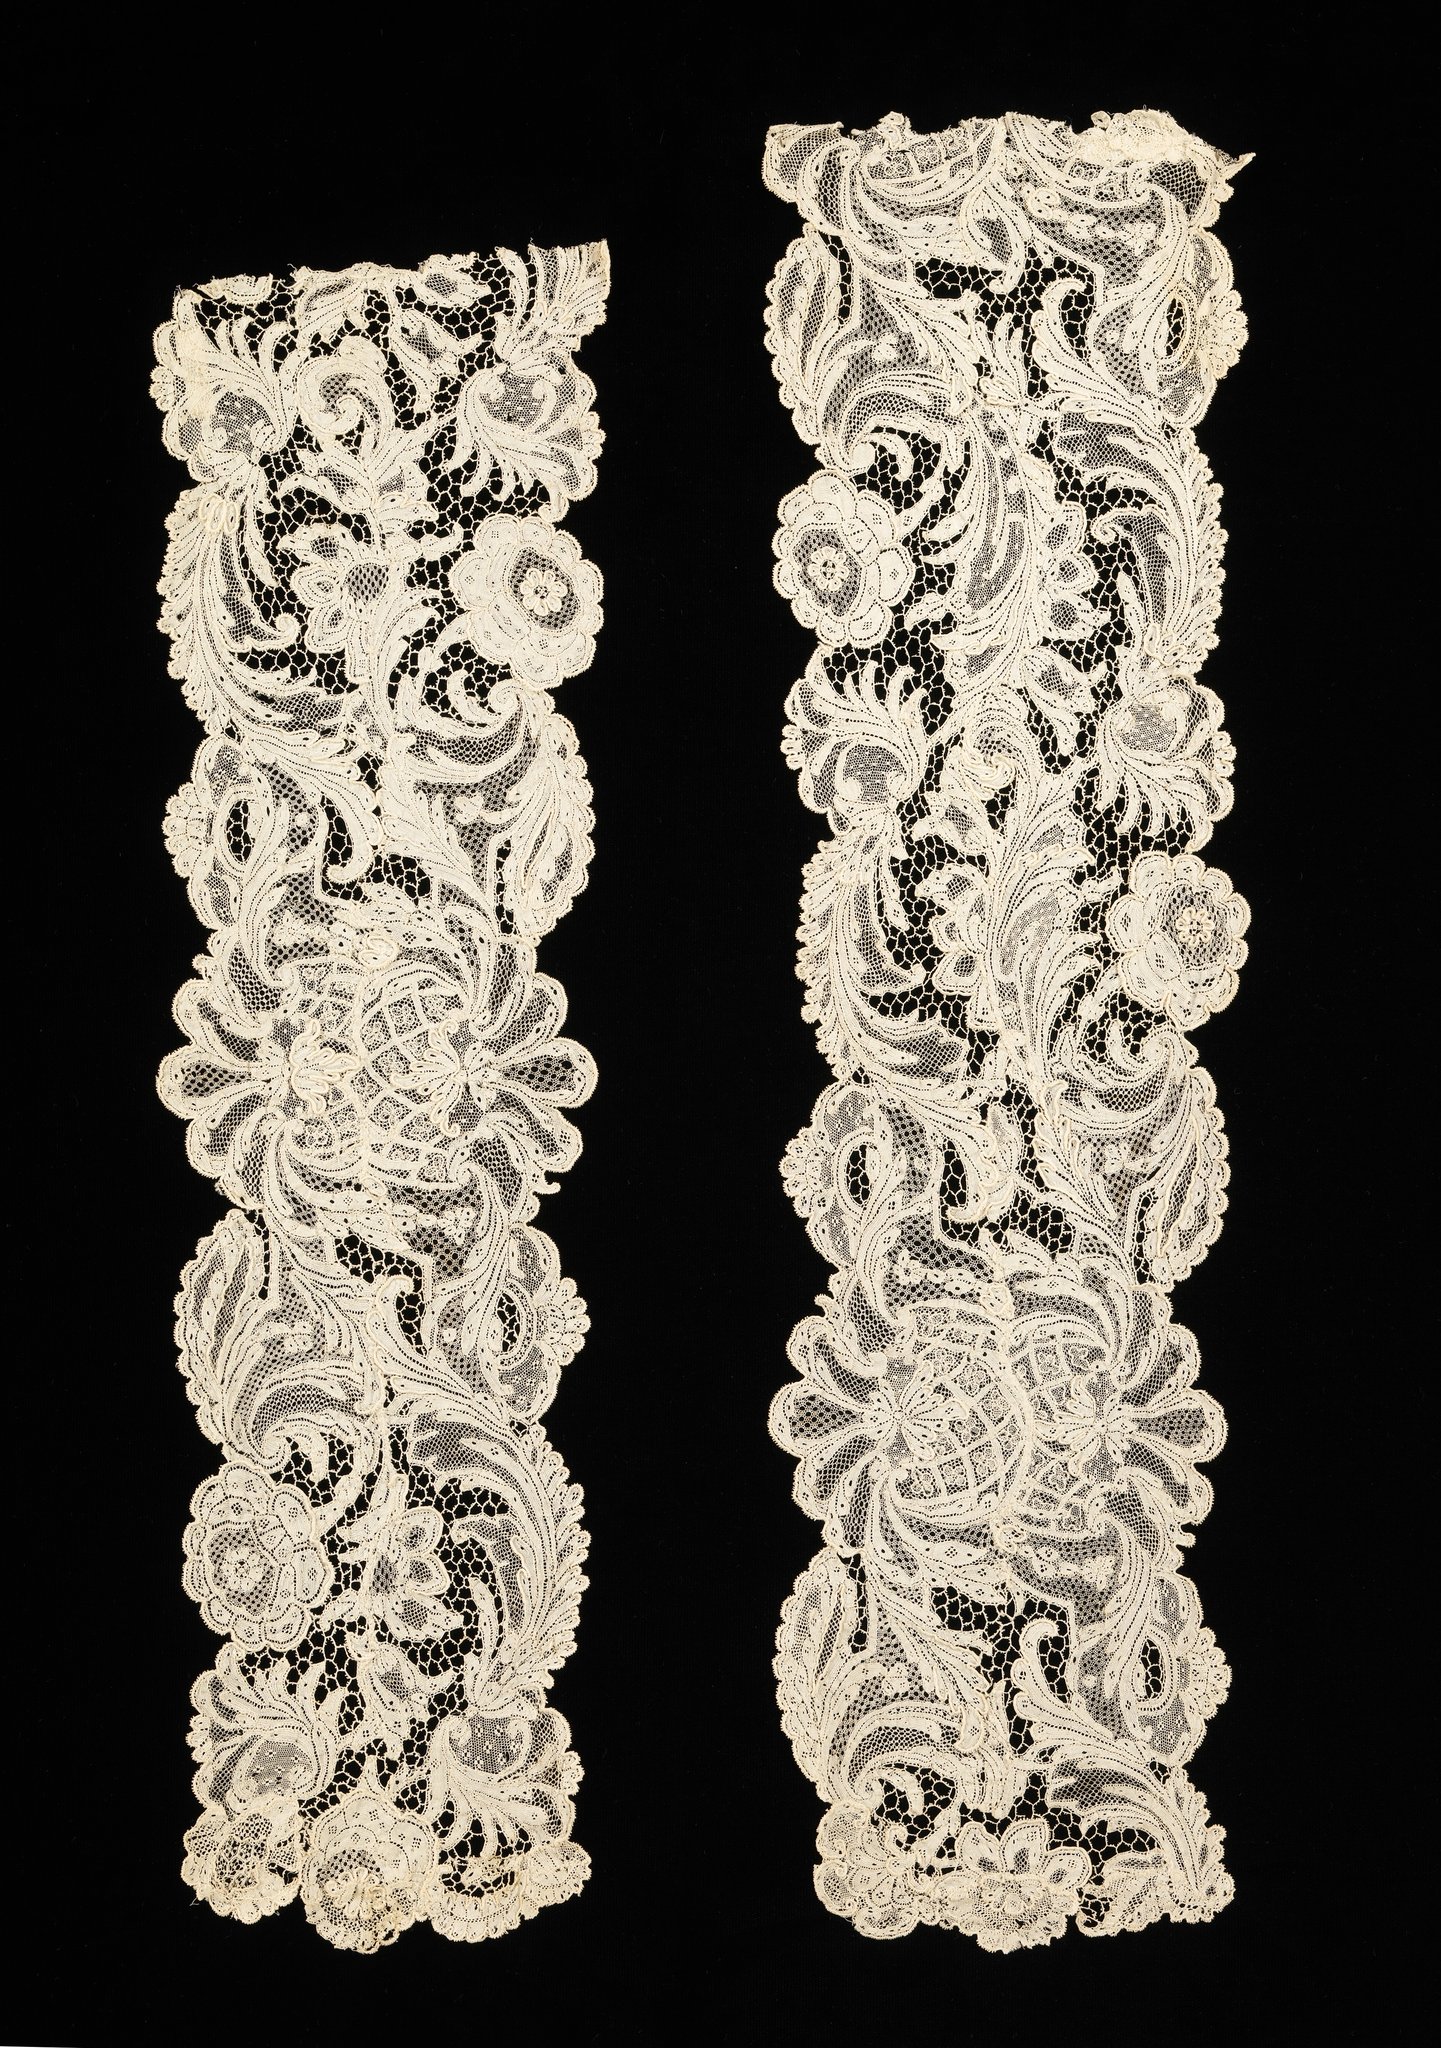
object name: lappet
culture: french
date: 1730-1739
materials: linen